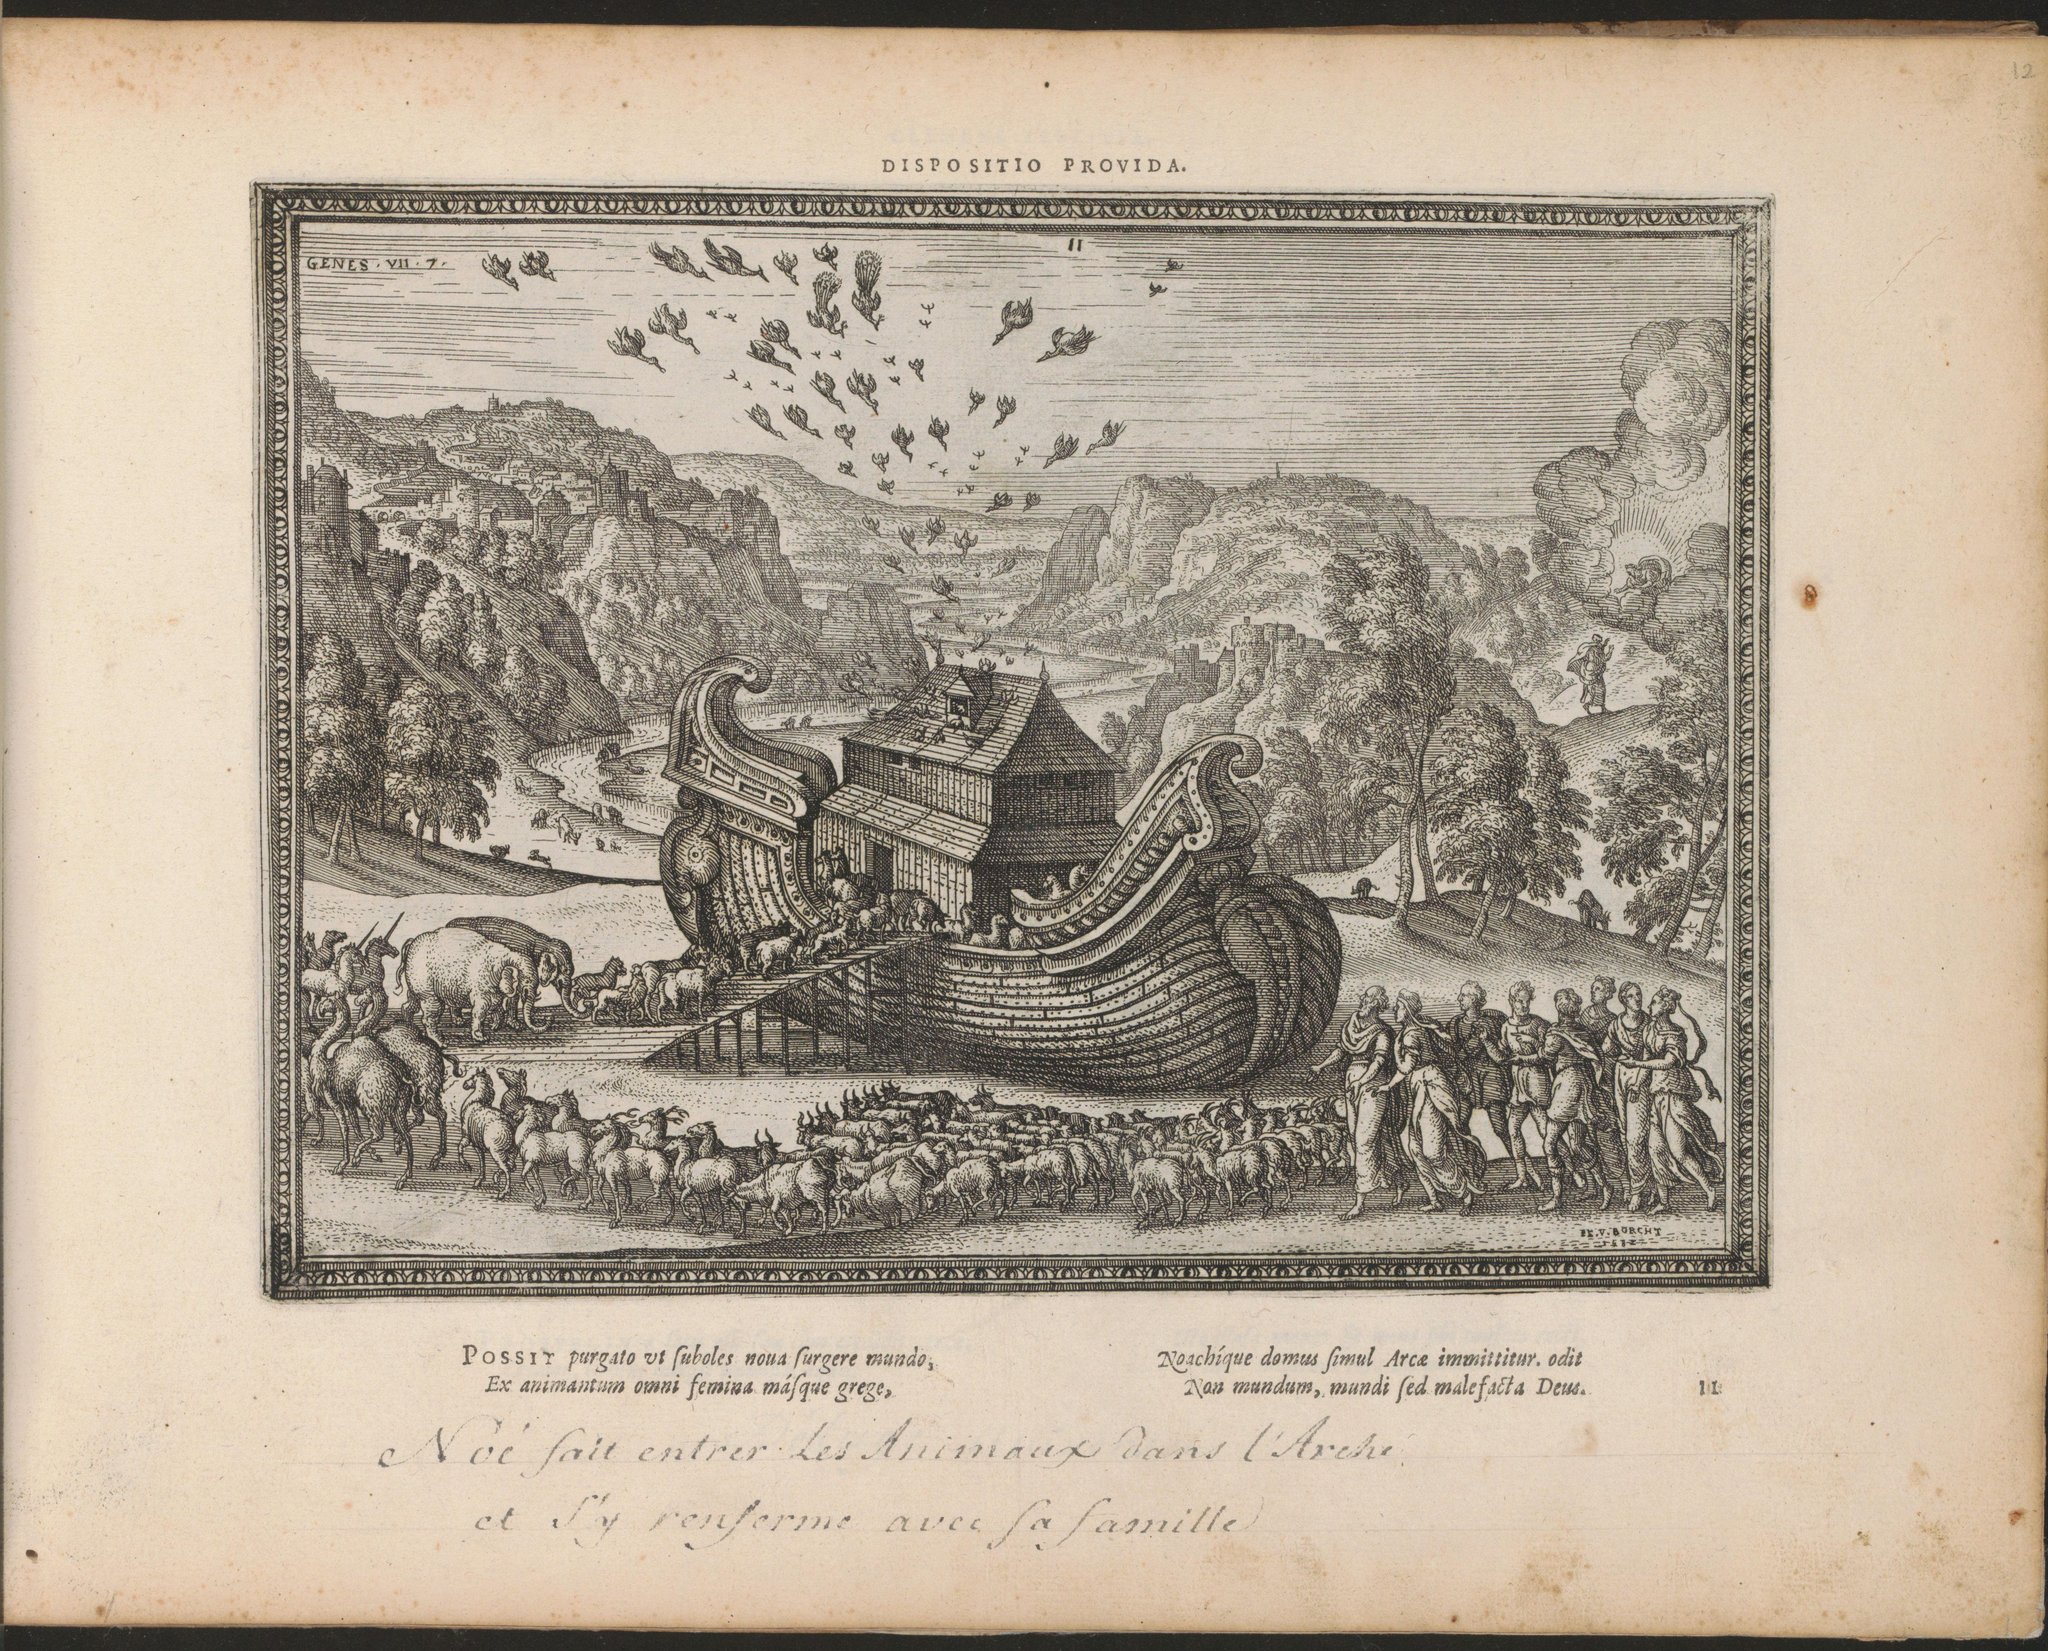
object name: print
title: Dispositio provida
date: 1582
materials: paper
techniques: etching, letterpress printing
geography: amsterdam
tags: the animals enter the ark, noah and his family enter the ark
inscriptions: inscription: ‘Noé fait entres les Animaux dans l'Arche et s'y renferme avec sa famille’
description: Een stoet van dieren trekt de ark binnen. Boven de ark een zwerm vogels. Rechts staat Noach met zijn vrouw, zijn zonen en de vrouwen van zijn zonen (Gen. 7:7). Met een motto in het Latijn boven de voorstelling en een vierregelig onderschrift in het Latijn onder de prent. De prent maakt deel uit van een album.